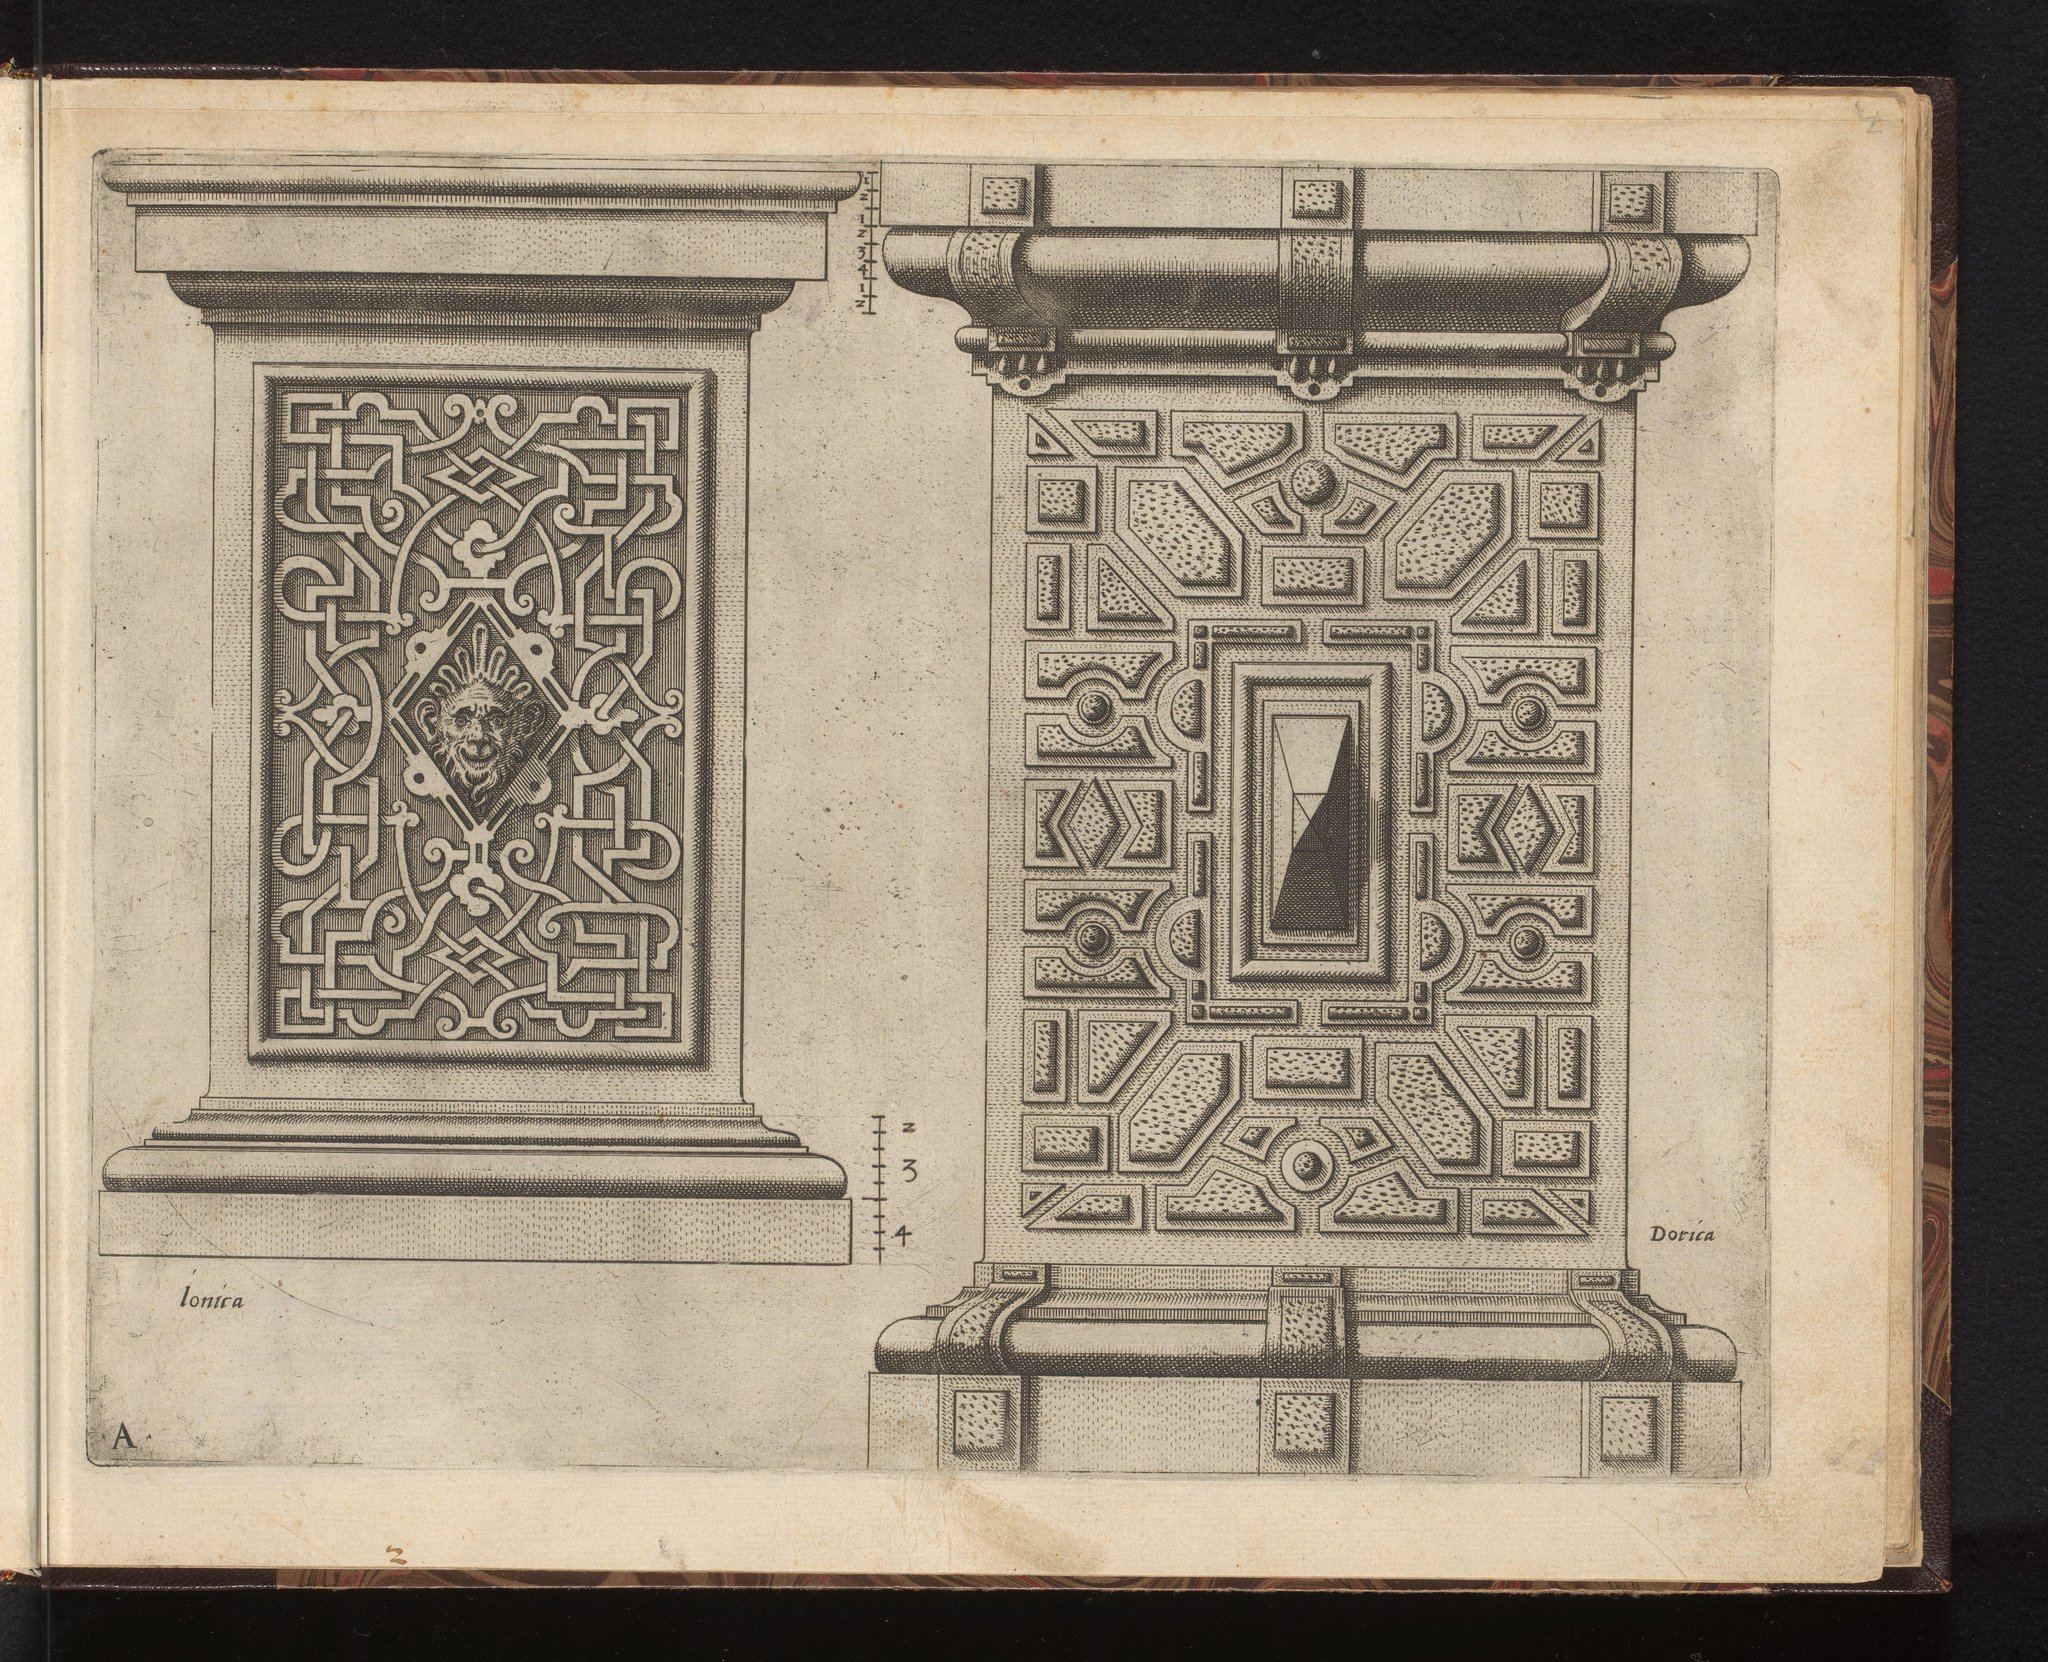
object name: album leaf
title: Twee piëdestals, in de Ionische en Dorische Orde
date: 1565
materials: paper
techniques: etching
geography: antwerp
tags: doric order ~ architecture, pedestal of a piece of sculpture (perhaps in the form of a herm), ionic order ~ architecture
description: Twee piëdestals. Links een Ionische piëdestal met een mascaron in een omlijsting van moresken. Rechts een Dorische piëdestal met gestileerde bossage. Op de voorstelling is twee keer een schaalverdeling aangegeven. Blad A. De prent maakt deel uit van een album.